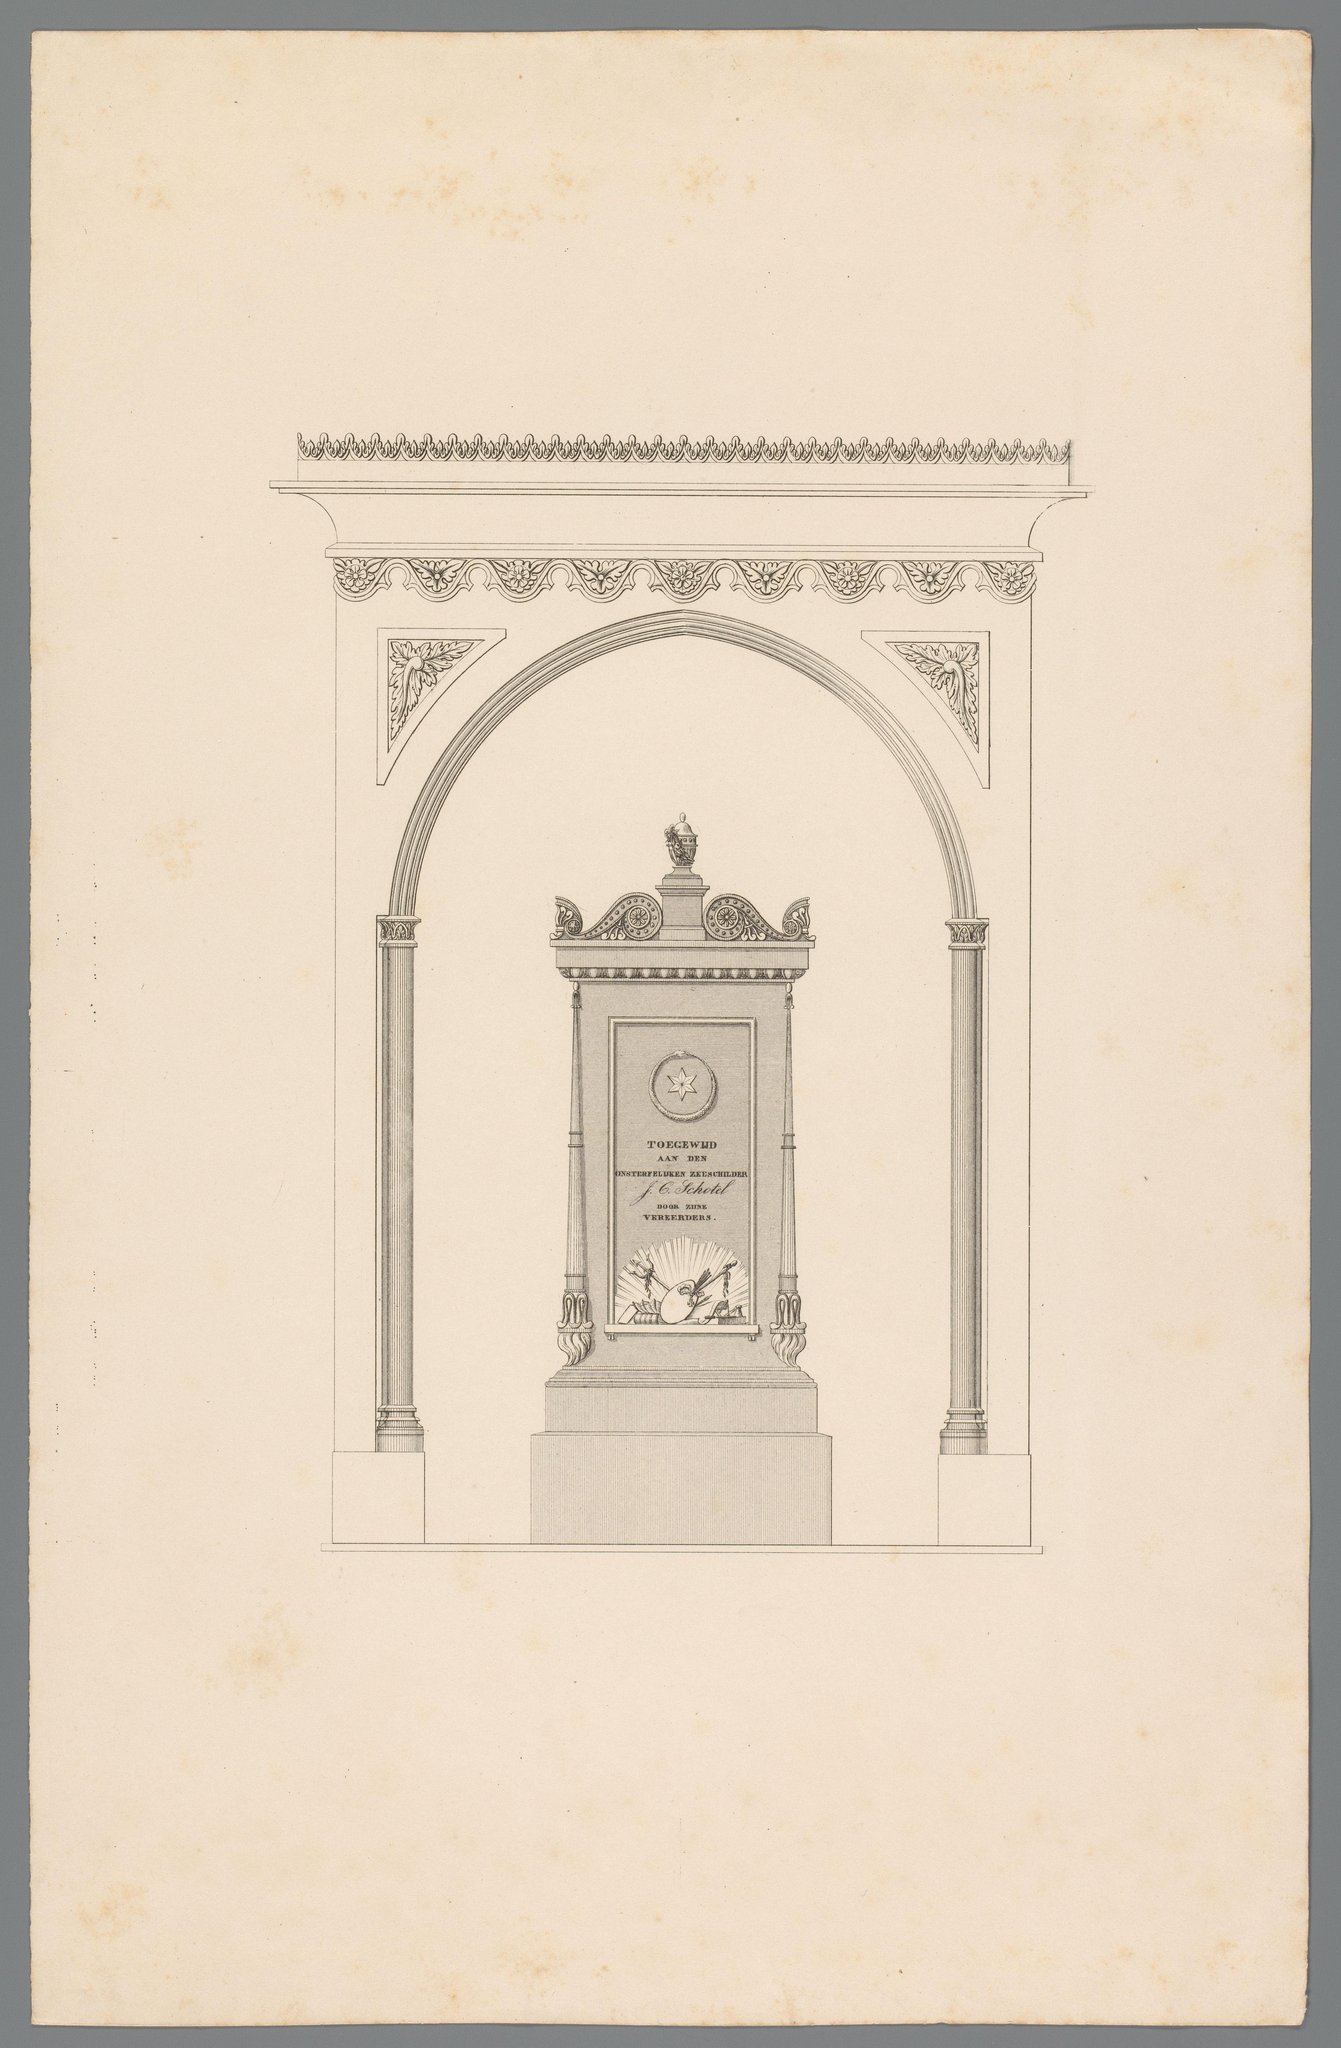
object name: print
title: Grafmonument voor schilder Johannes Christiaan Schotel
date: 1839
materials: paper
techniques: lithograph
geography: amsterdam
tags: print maker, draughtsman, johannes christiaan schotel, knighthood order, grave, tomb, palette, epitaph, dordrecht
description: Monument voor schilder Johannes Christiaan Schotel in de Grote Kerk te Dordrecht. Het graf staat op een sokkel en is gedecoreerd met een eierlijst, voluten en een grafurn. Erop afgebeeld schildersattributen, nautische instrumenten, lauriertakken en een ridderorde. Het geheel is geplaatst onder een spitsboog en wordt geflankeerd door twee zuilen.